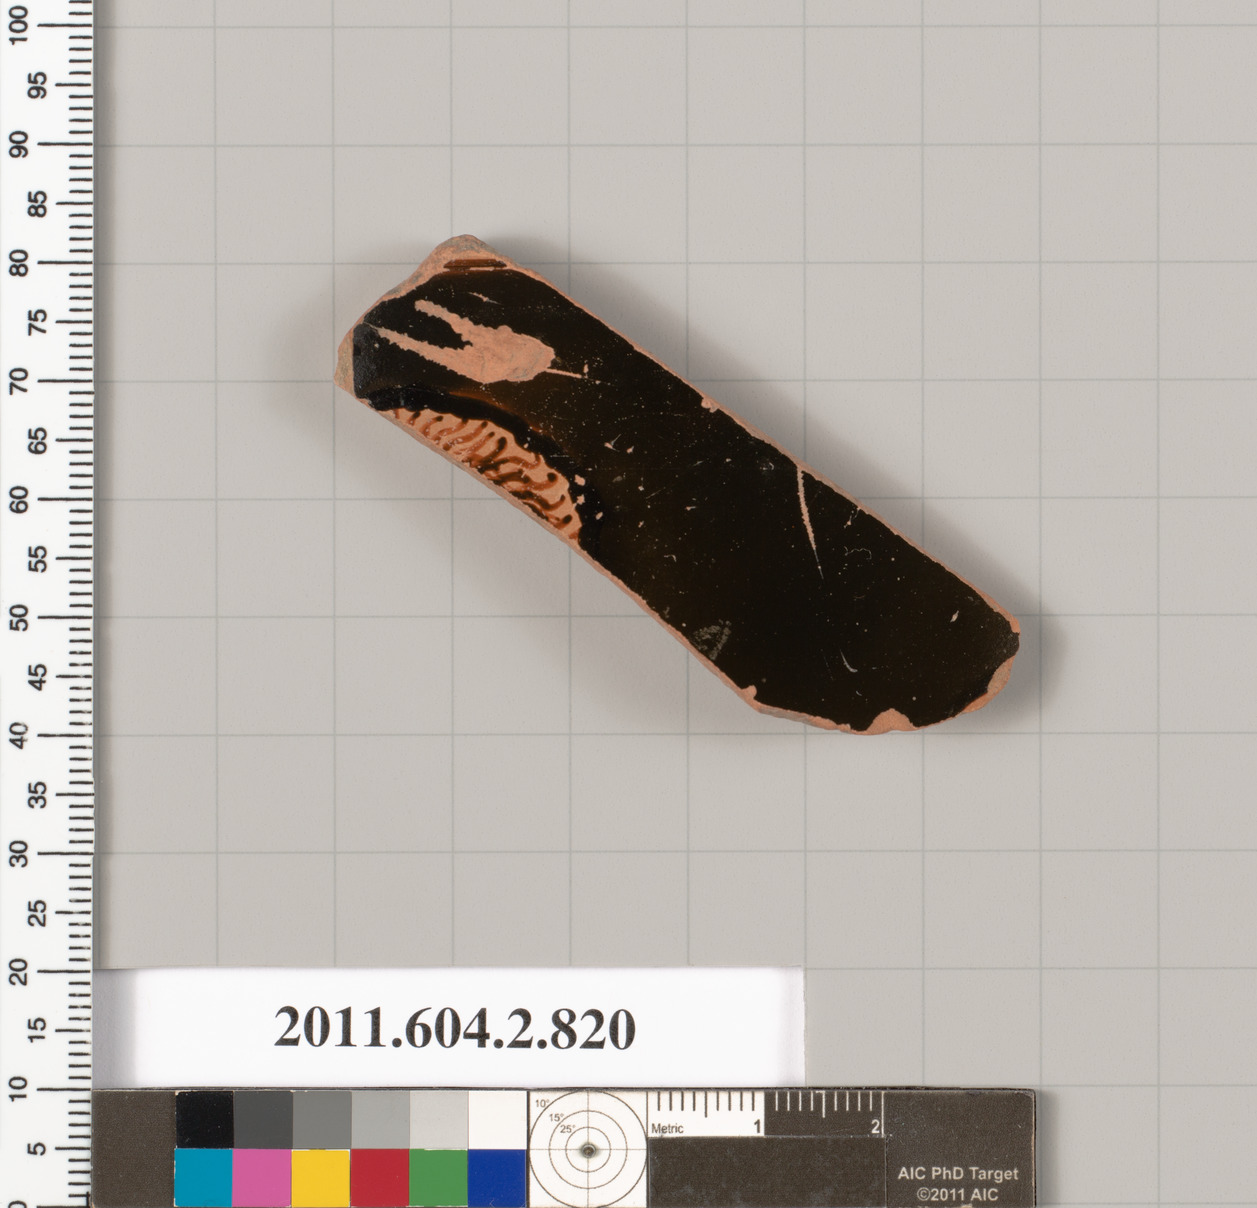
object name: bell krater fragment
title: Terracotta fragment of a bell-krater (bowl for mixing wine and water)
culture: greek, attic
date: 460-450 BCE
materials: terracotta